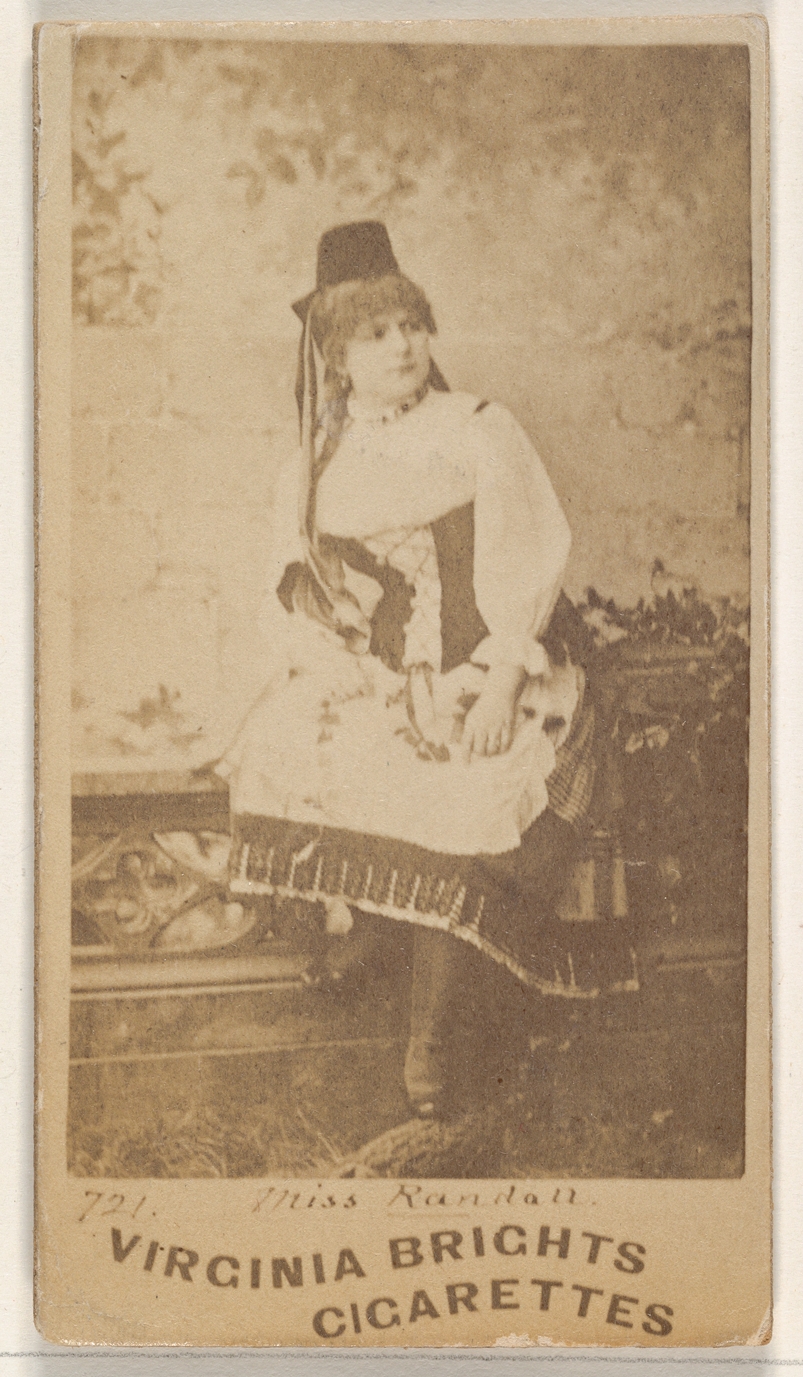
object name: photograph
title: Card 721, Miss Randall, from the Actors and Actresses series (N45, Type 1) for Virginia Brights Cigarettes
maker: allen & ginter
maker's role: publisher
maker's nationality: american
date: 1888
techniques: albumen silver print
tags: portraits,women,actresses